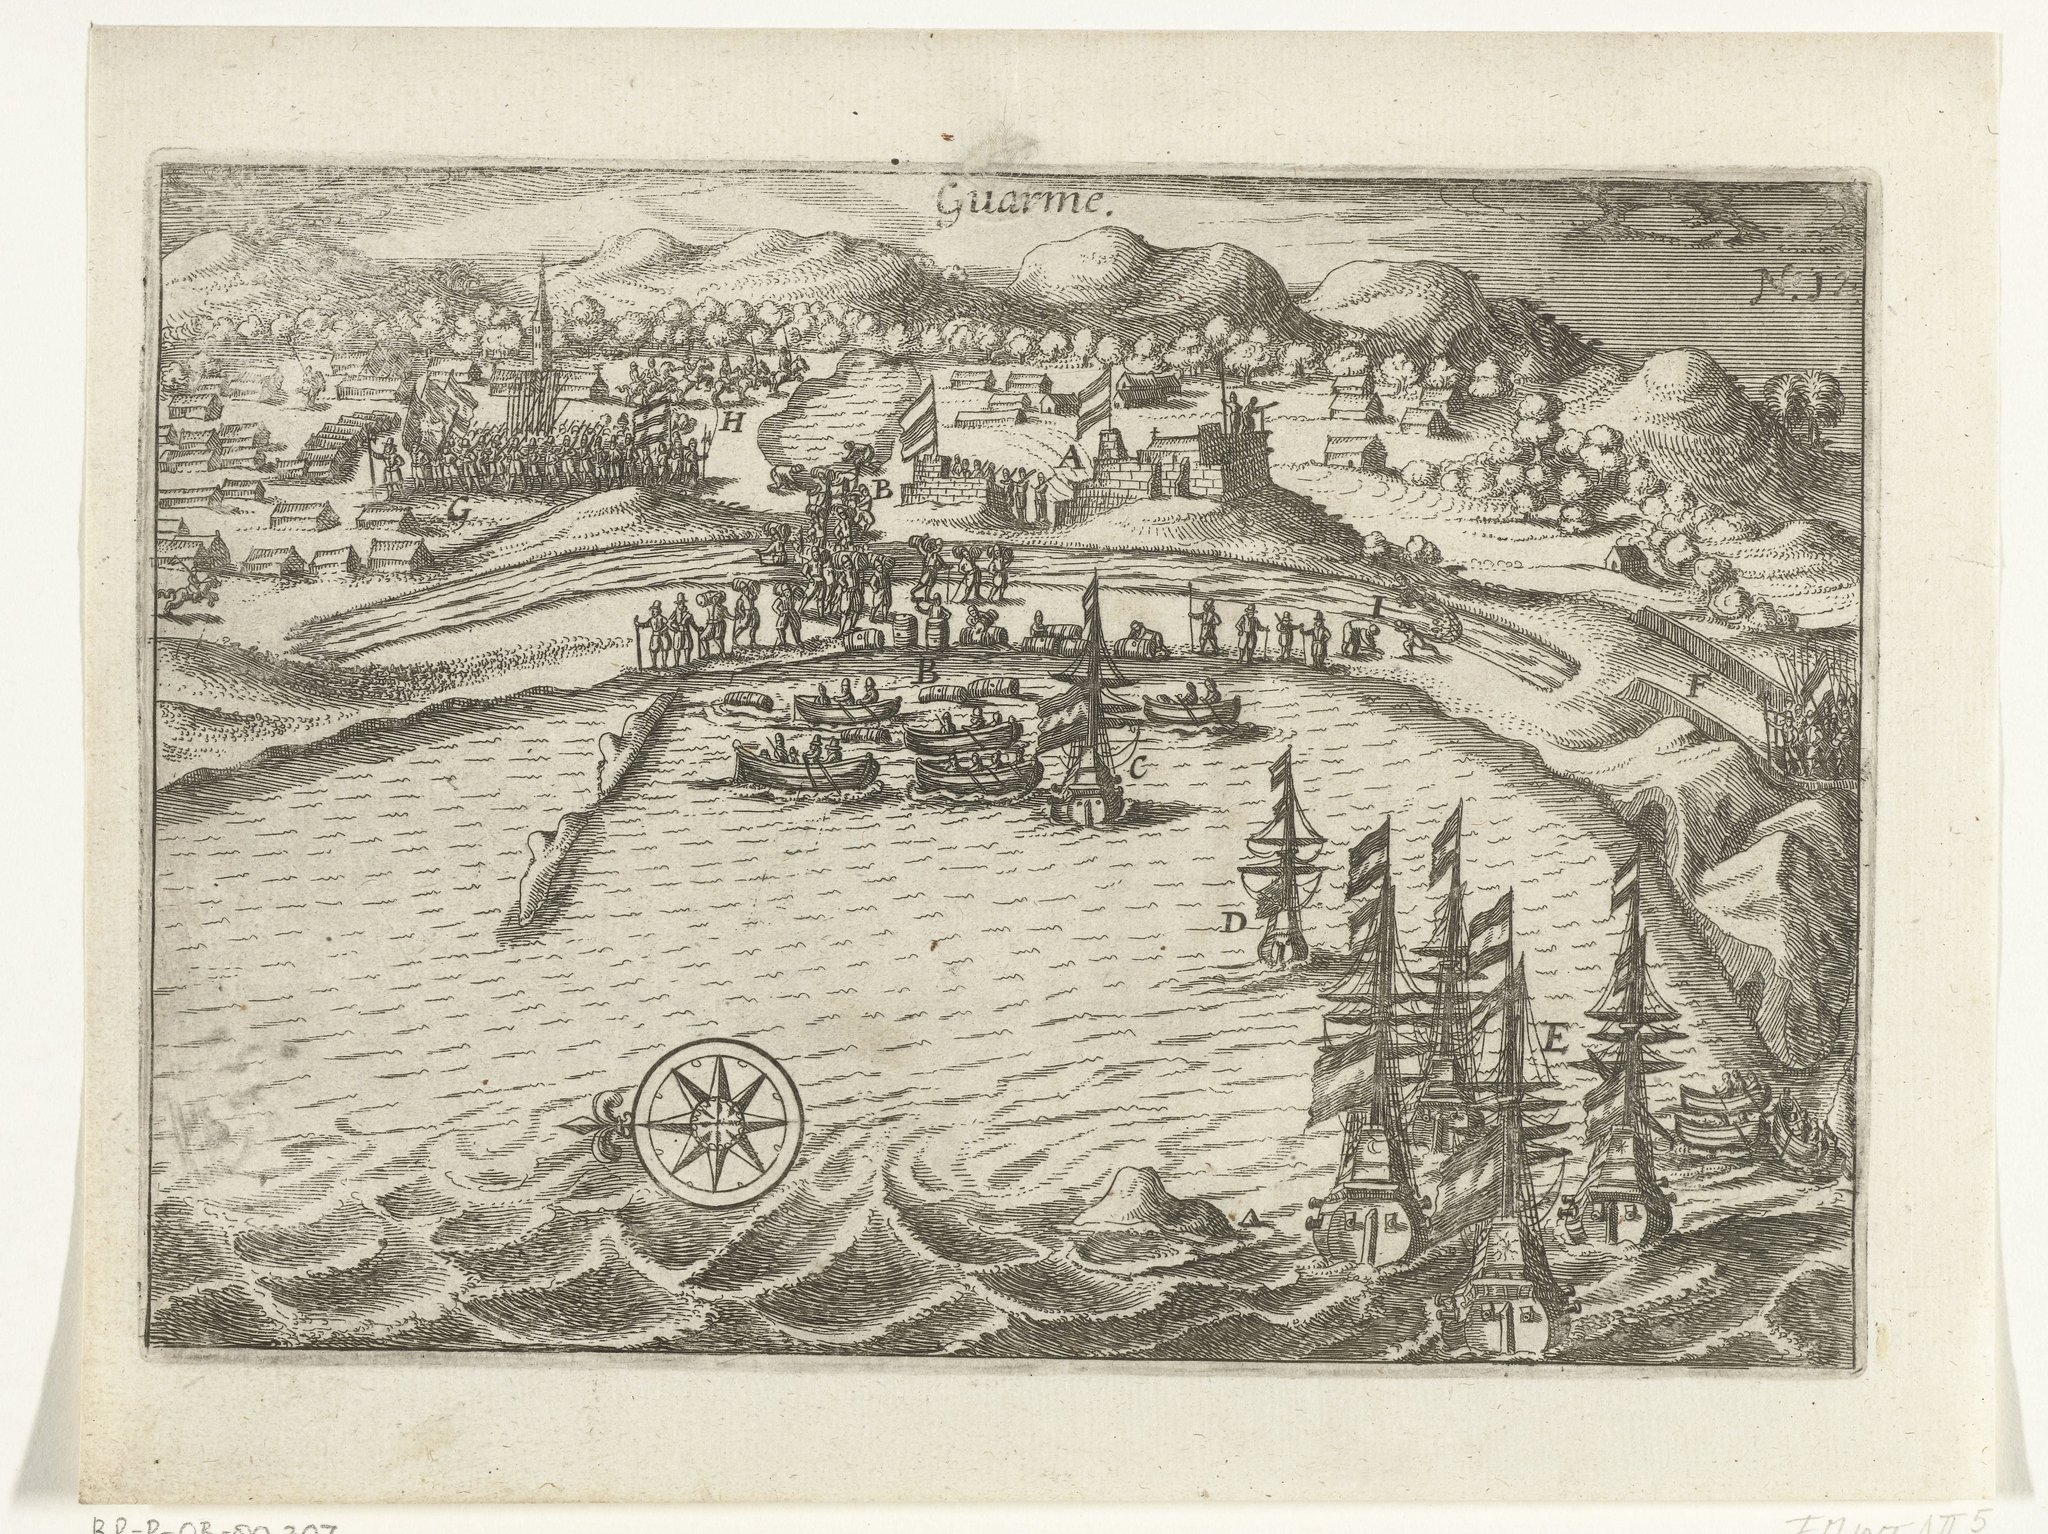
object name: print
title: Afbeeldinghe van Guarme, Alwaer onse Schepen ververschten, ende met groote moeyten haer water met tonnen over het strandt brenghen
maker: Anonymous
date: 1617-1619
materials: paper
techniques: etching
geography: northern netherlands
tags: antwerp, bergen op zoom, landscapes in tropical and sub-tropical regions, exploration, expedition, voyage of discovery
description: Gebruikt als illustratie eerst in: J. van Spilbergen, Oost ende West-Indische spiegel der 2 leste navigatiën, ghedaen inden jaeren 1614, 15, 16, 17, ende 18. daer in vertoont woort, in wat gestalt Ioris van Speilbergen door de Magellanes de werelt rontom geseylt heeft ...; met de Australische navigatiën, van Iacob le Maire, ... met veel wonders ... in 26 coperen platen afghebeelt, N. Geelkerck, Leiden 1619. Later opnieuw gebruikt in : I. Commelin, Begin ende voortgangh, van de Vereenighde Nederlantsche Geoctroyeerde Oost-Indische Compagnie, J. Janssonius, Amsterdam 1646. Genummerd: No. 12.